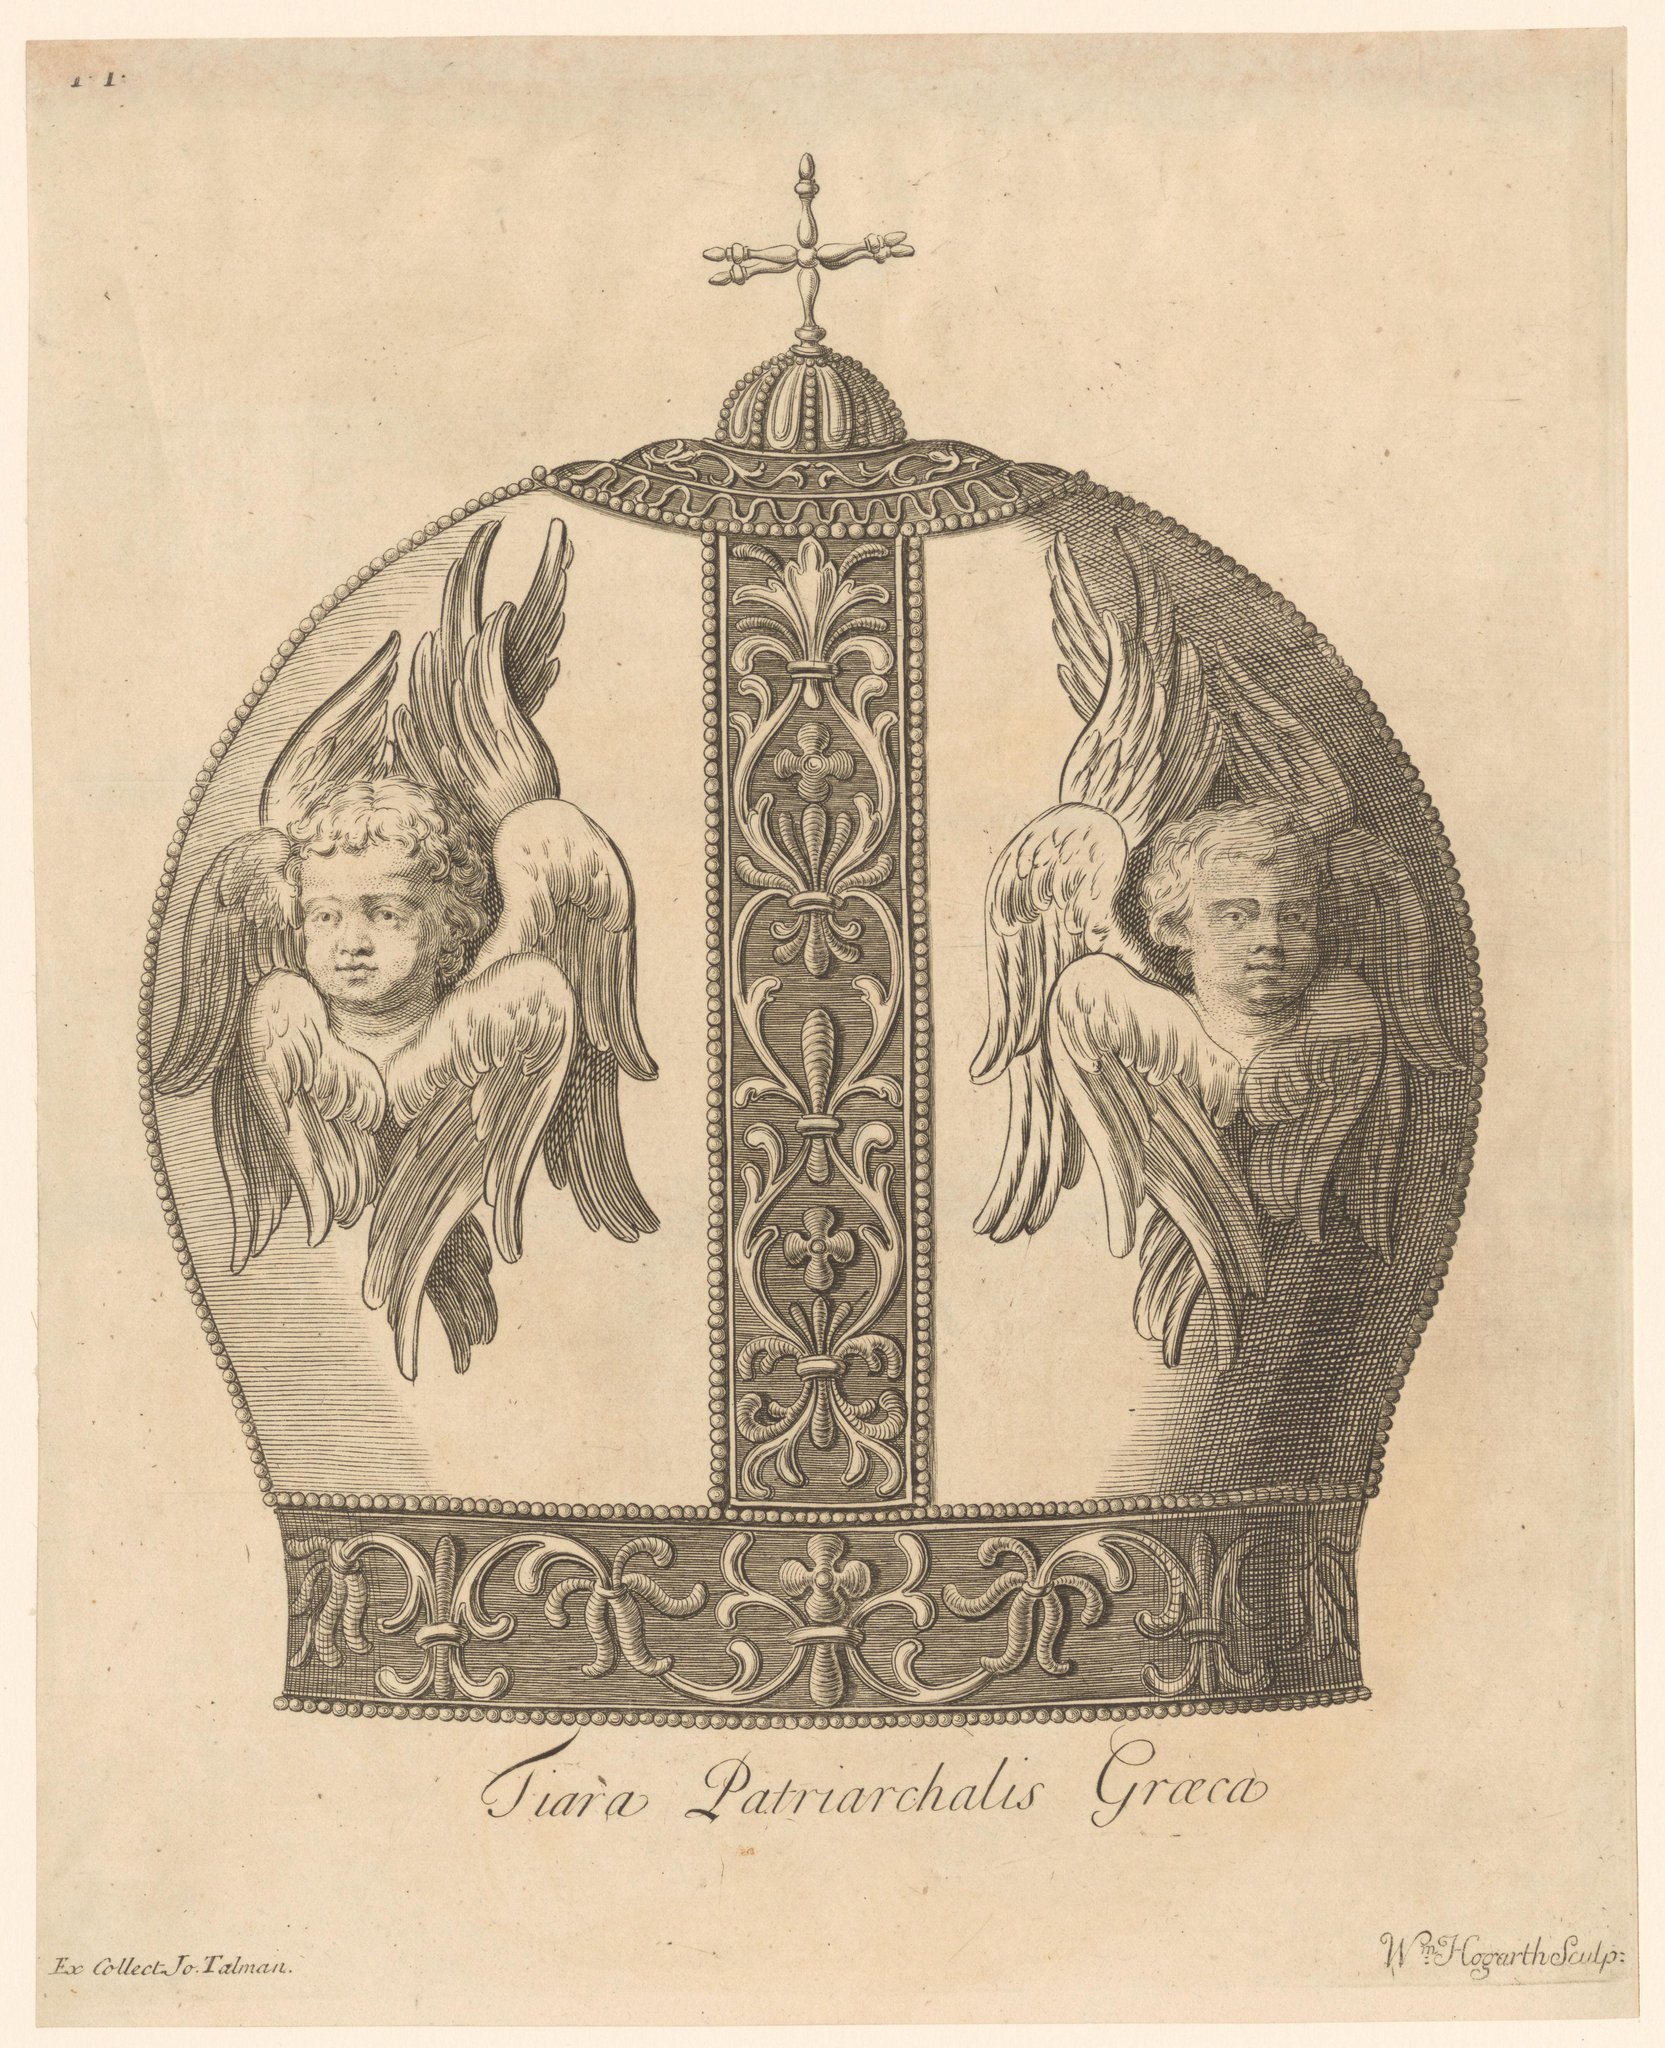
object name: print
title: Tiara Patriarchalis Graeca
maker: william hogarth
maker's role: draughtsman, painter, print maker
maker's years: 1697-1764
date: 1723-1724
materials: paper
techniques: engraving, etching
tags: crown (symbol of sovereignty), seraphim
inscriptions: collector's mark: Lugt 2228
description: Deze prent is gebruikt in: Mottraye, Aubry de La. Travels throughout Europe, Asia and into Part of Africa (...). Londen: s.n., [1723-1724], dl. 1, afb. 9. Dit is mogelijk de tiara van Methodius van Olympus.